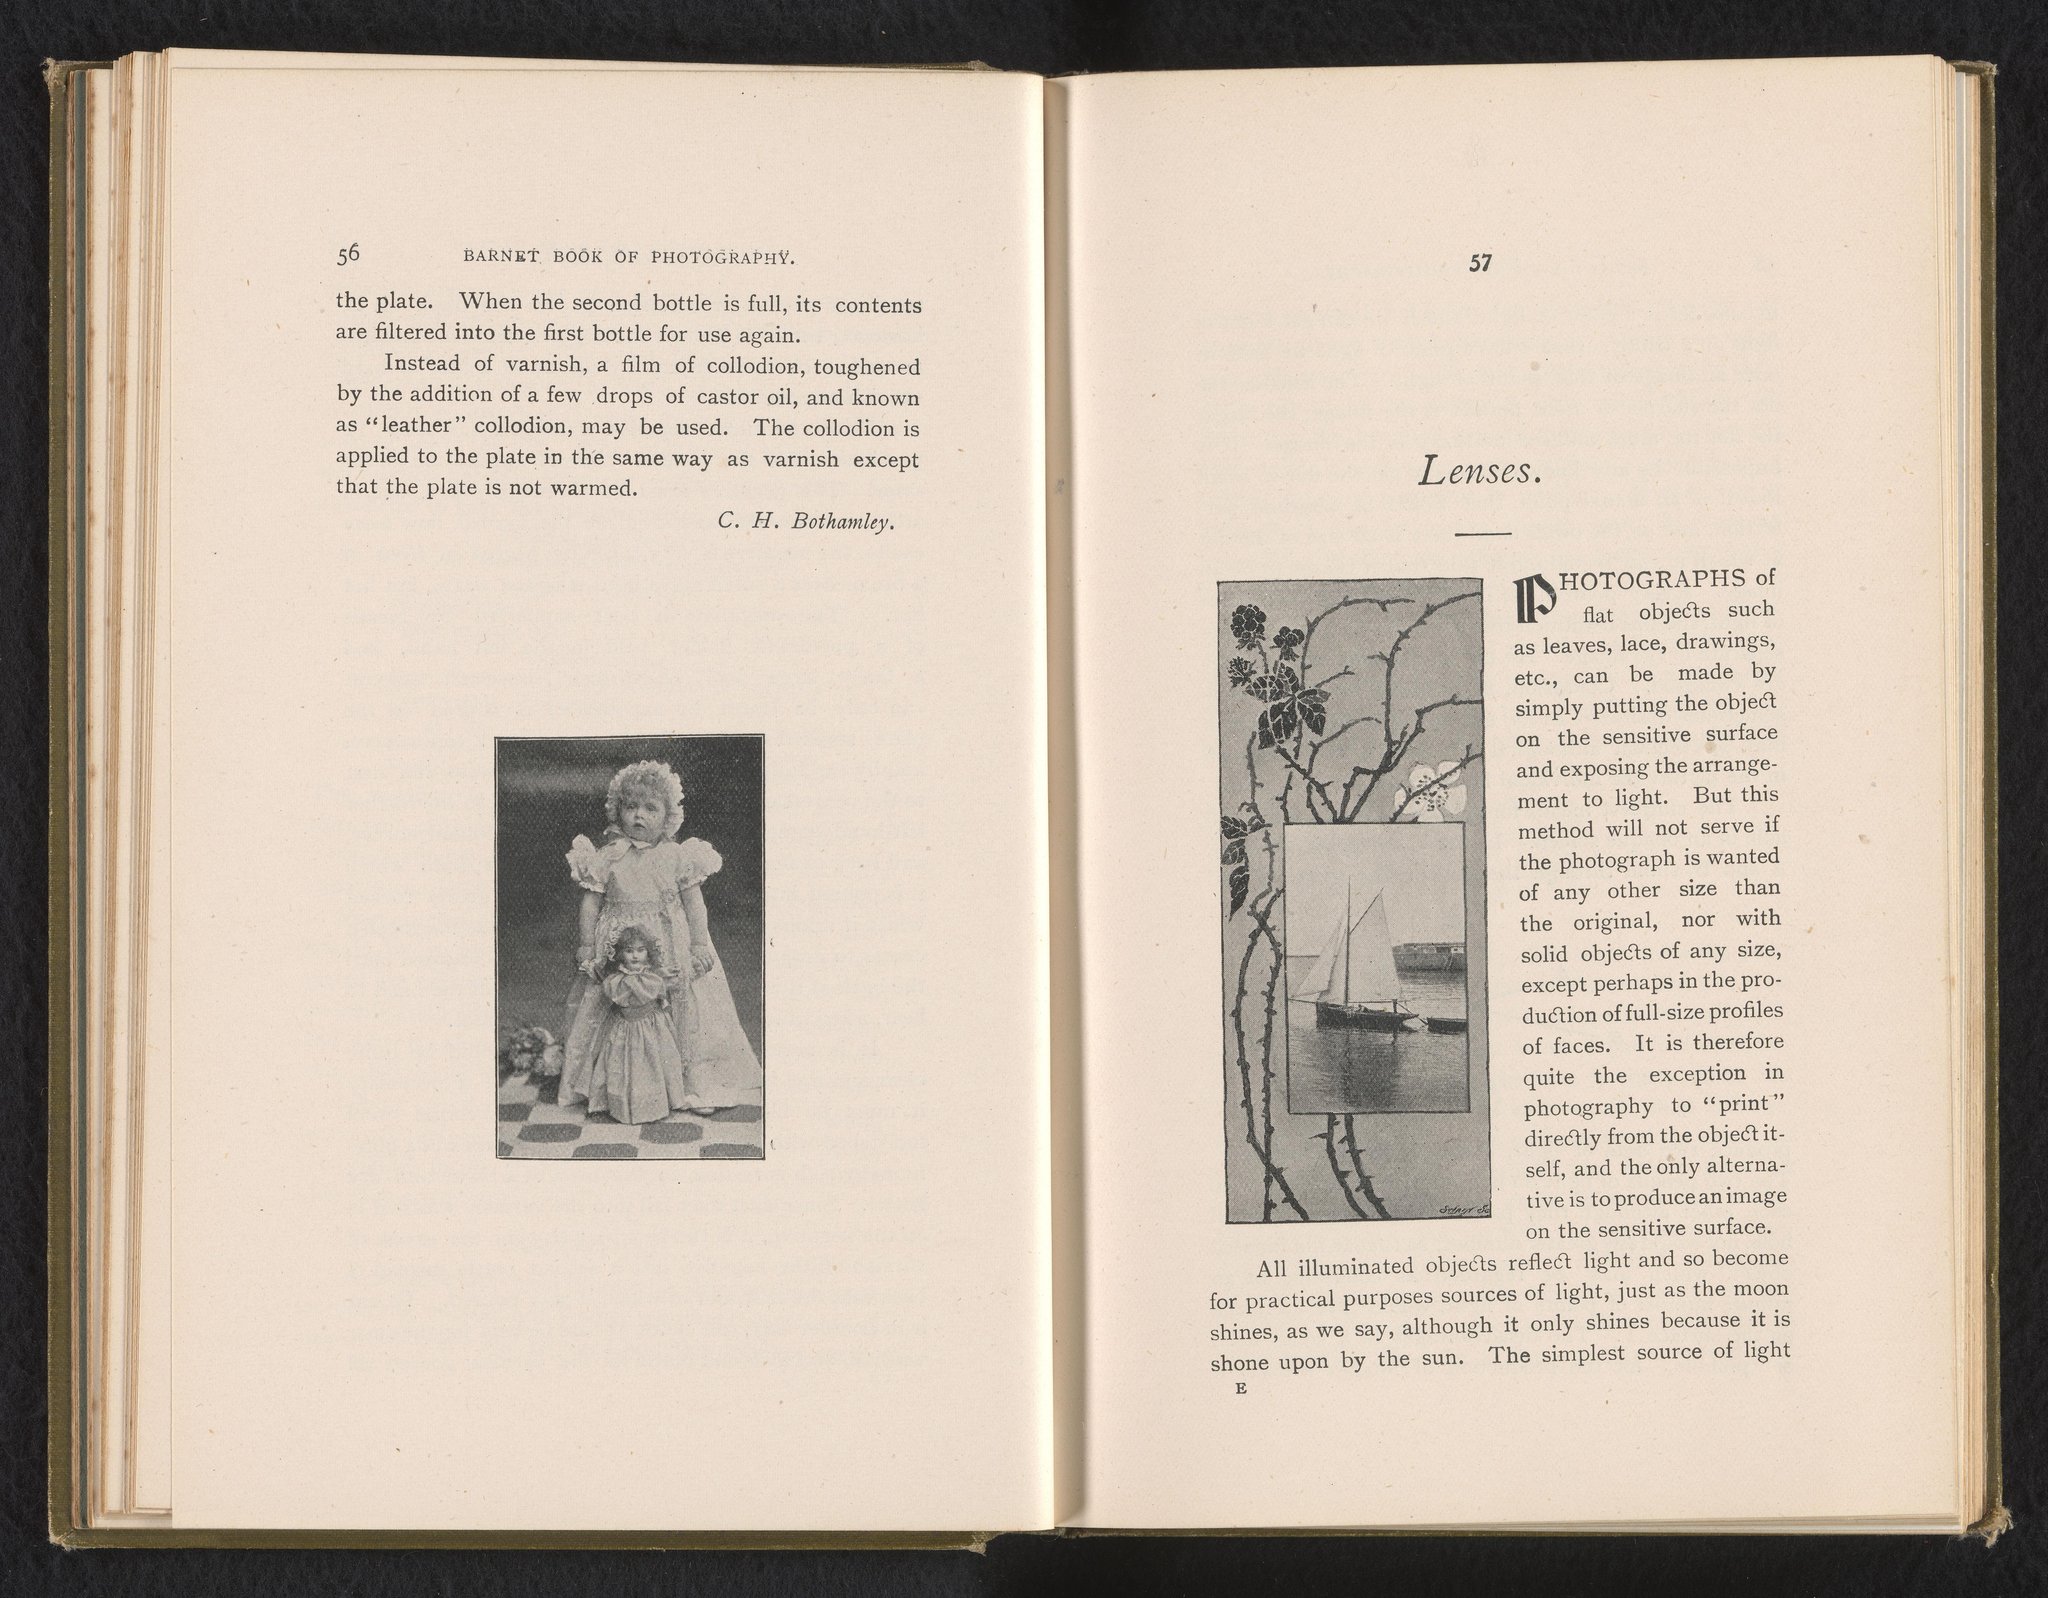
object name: page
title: Zeilboot omlijst met bramenstruik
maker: Anonymous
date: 1895-1900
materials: paper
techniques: letterpress printing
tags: sailing-ship, sailing-boat, shrubs: blackberry-bush